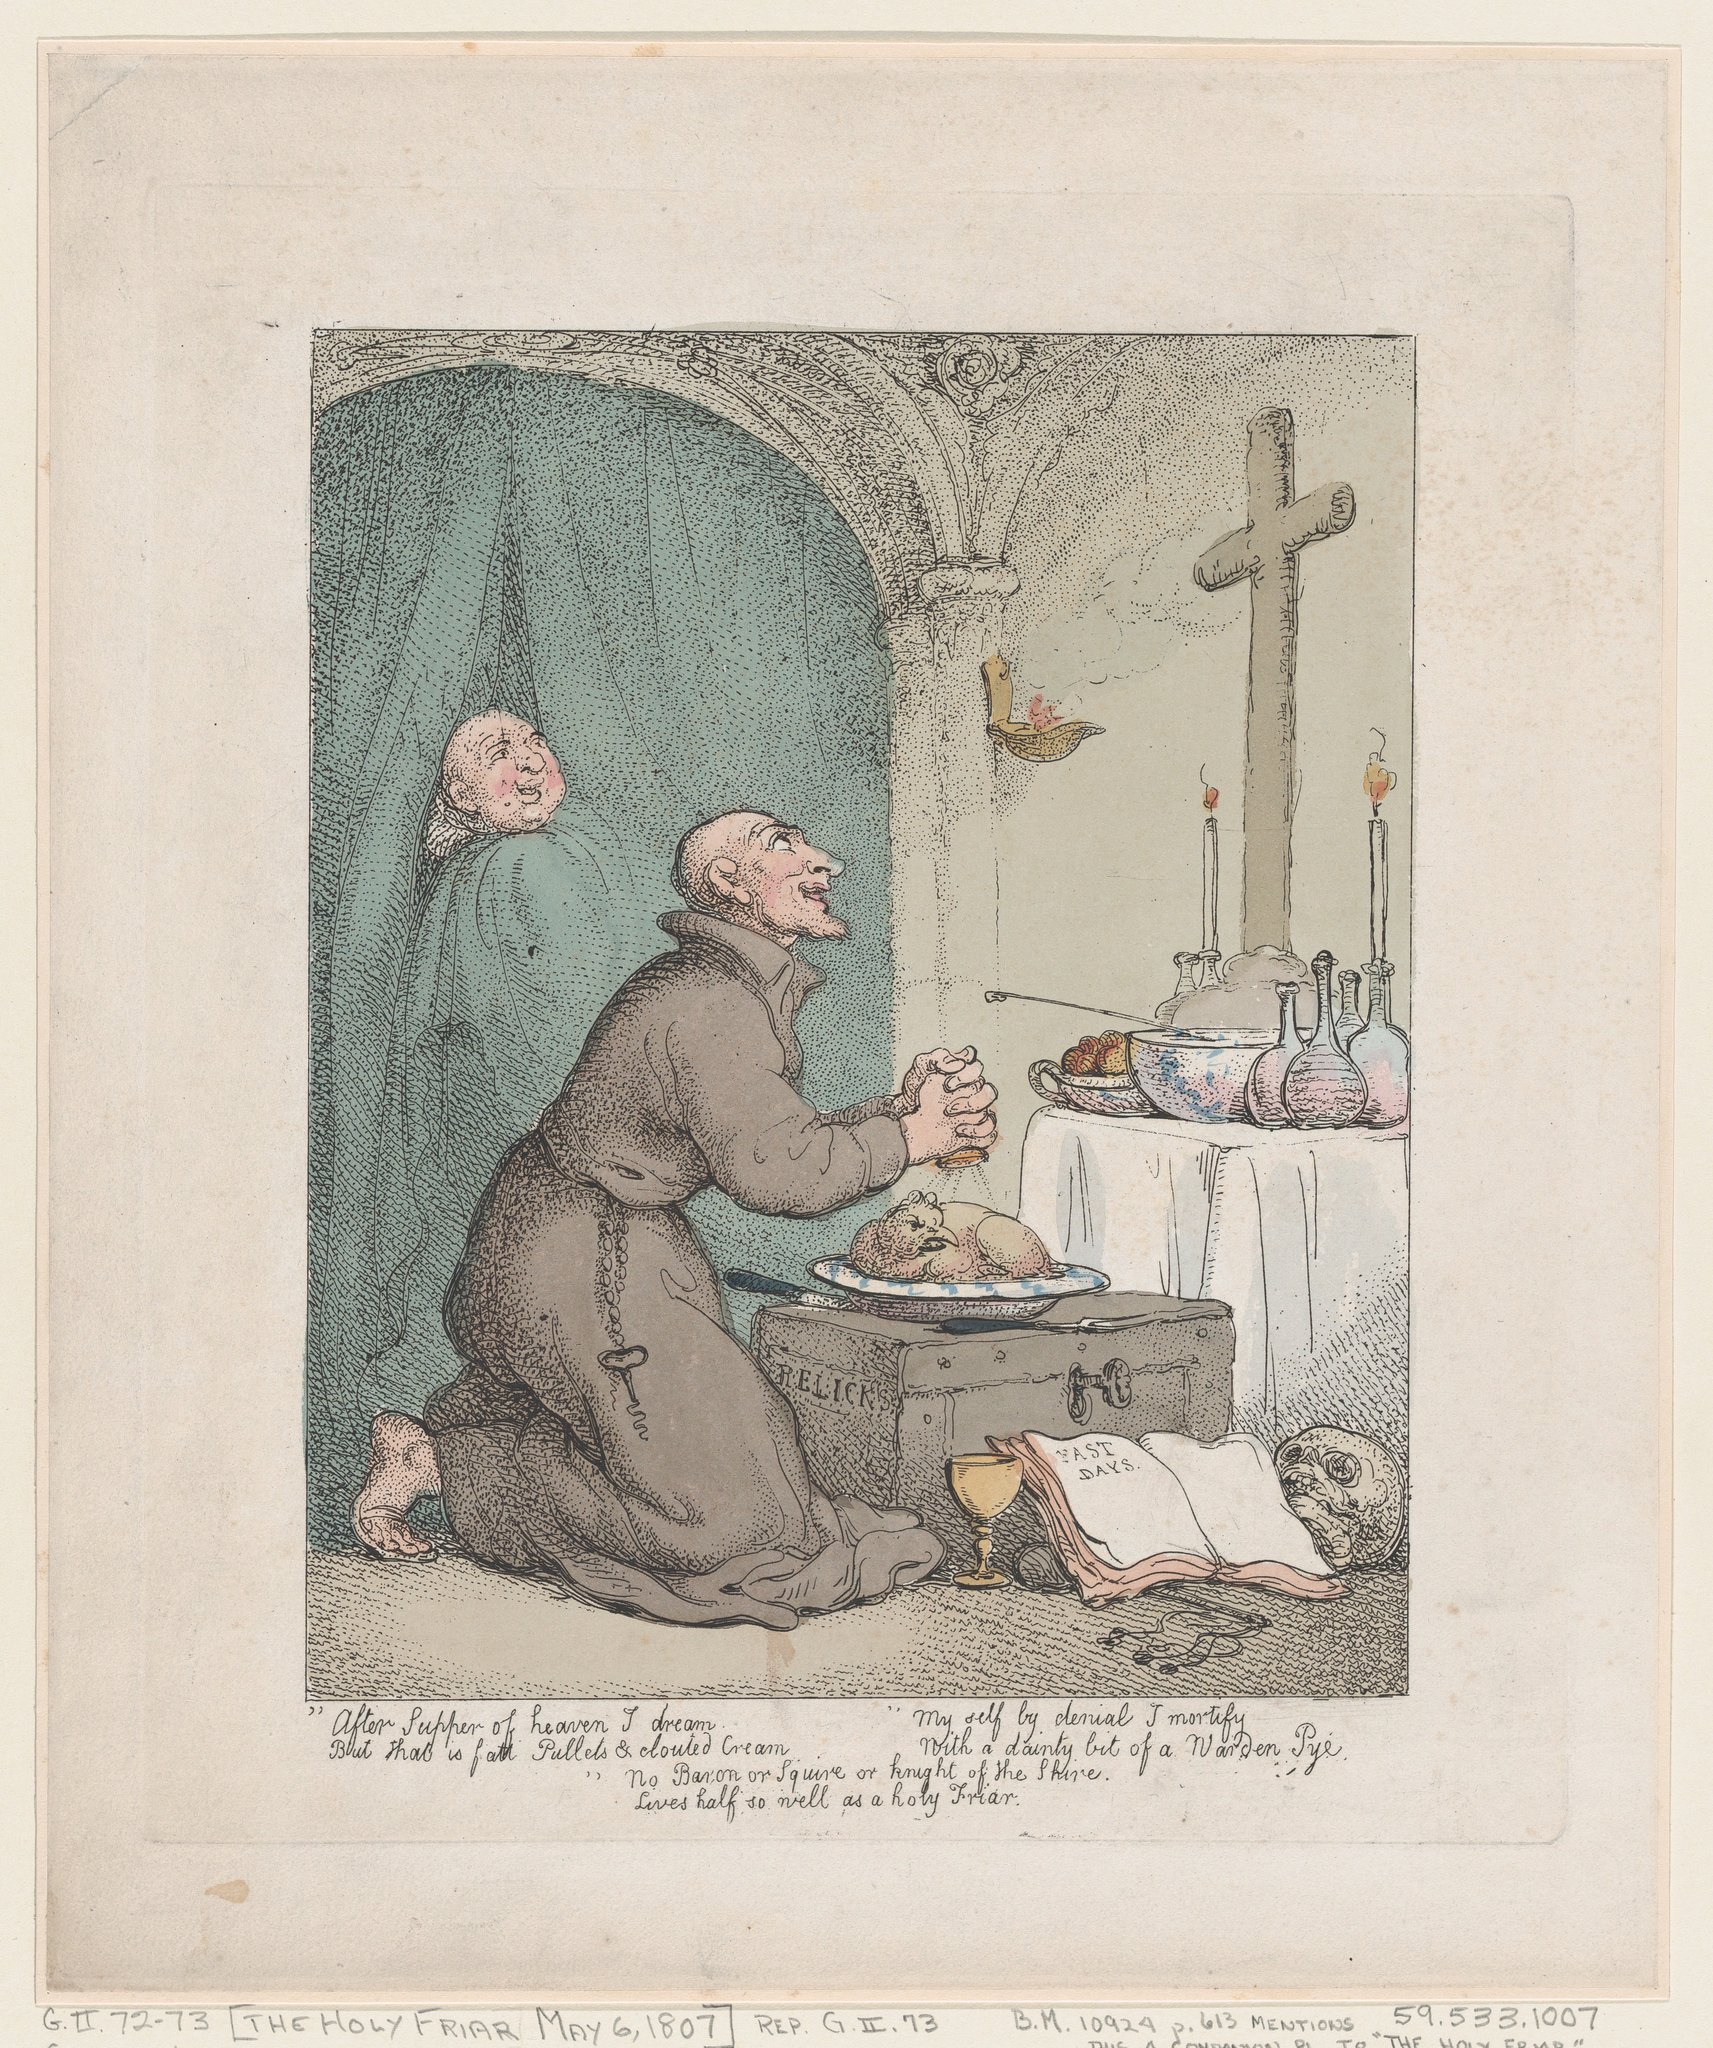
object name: print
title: The Holy Friar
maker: thomas rowlandson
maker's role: artist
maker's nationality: british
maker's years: 1757-1827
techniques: etching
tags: satire,men,cross